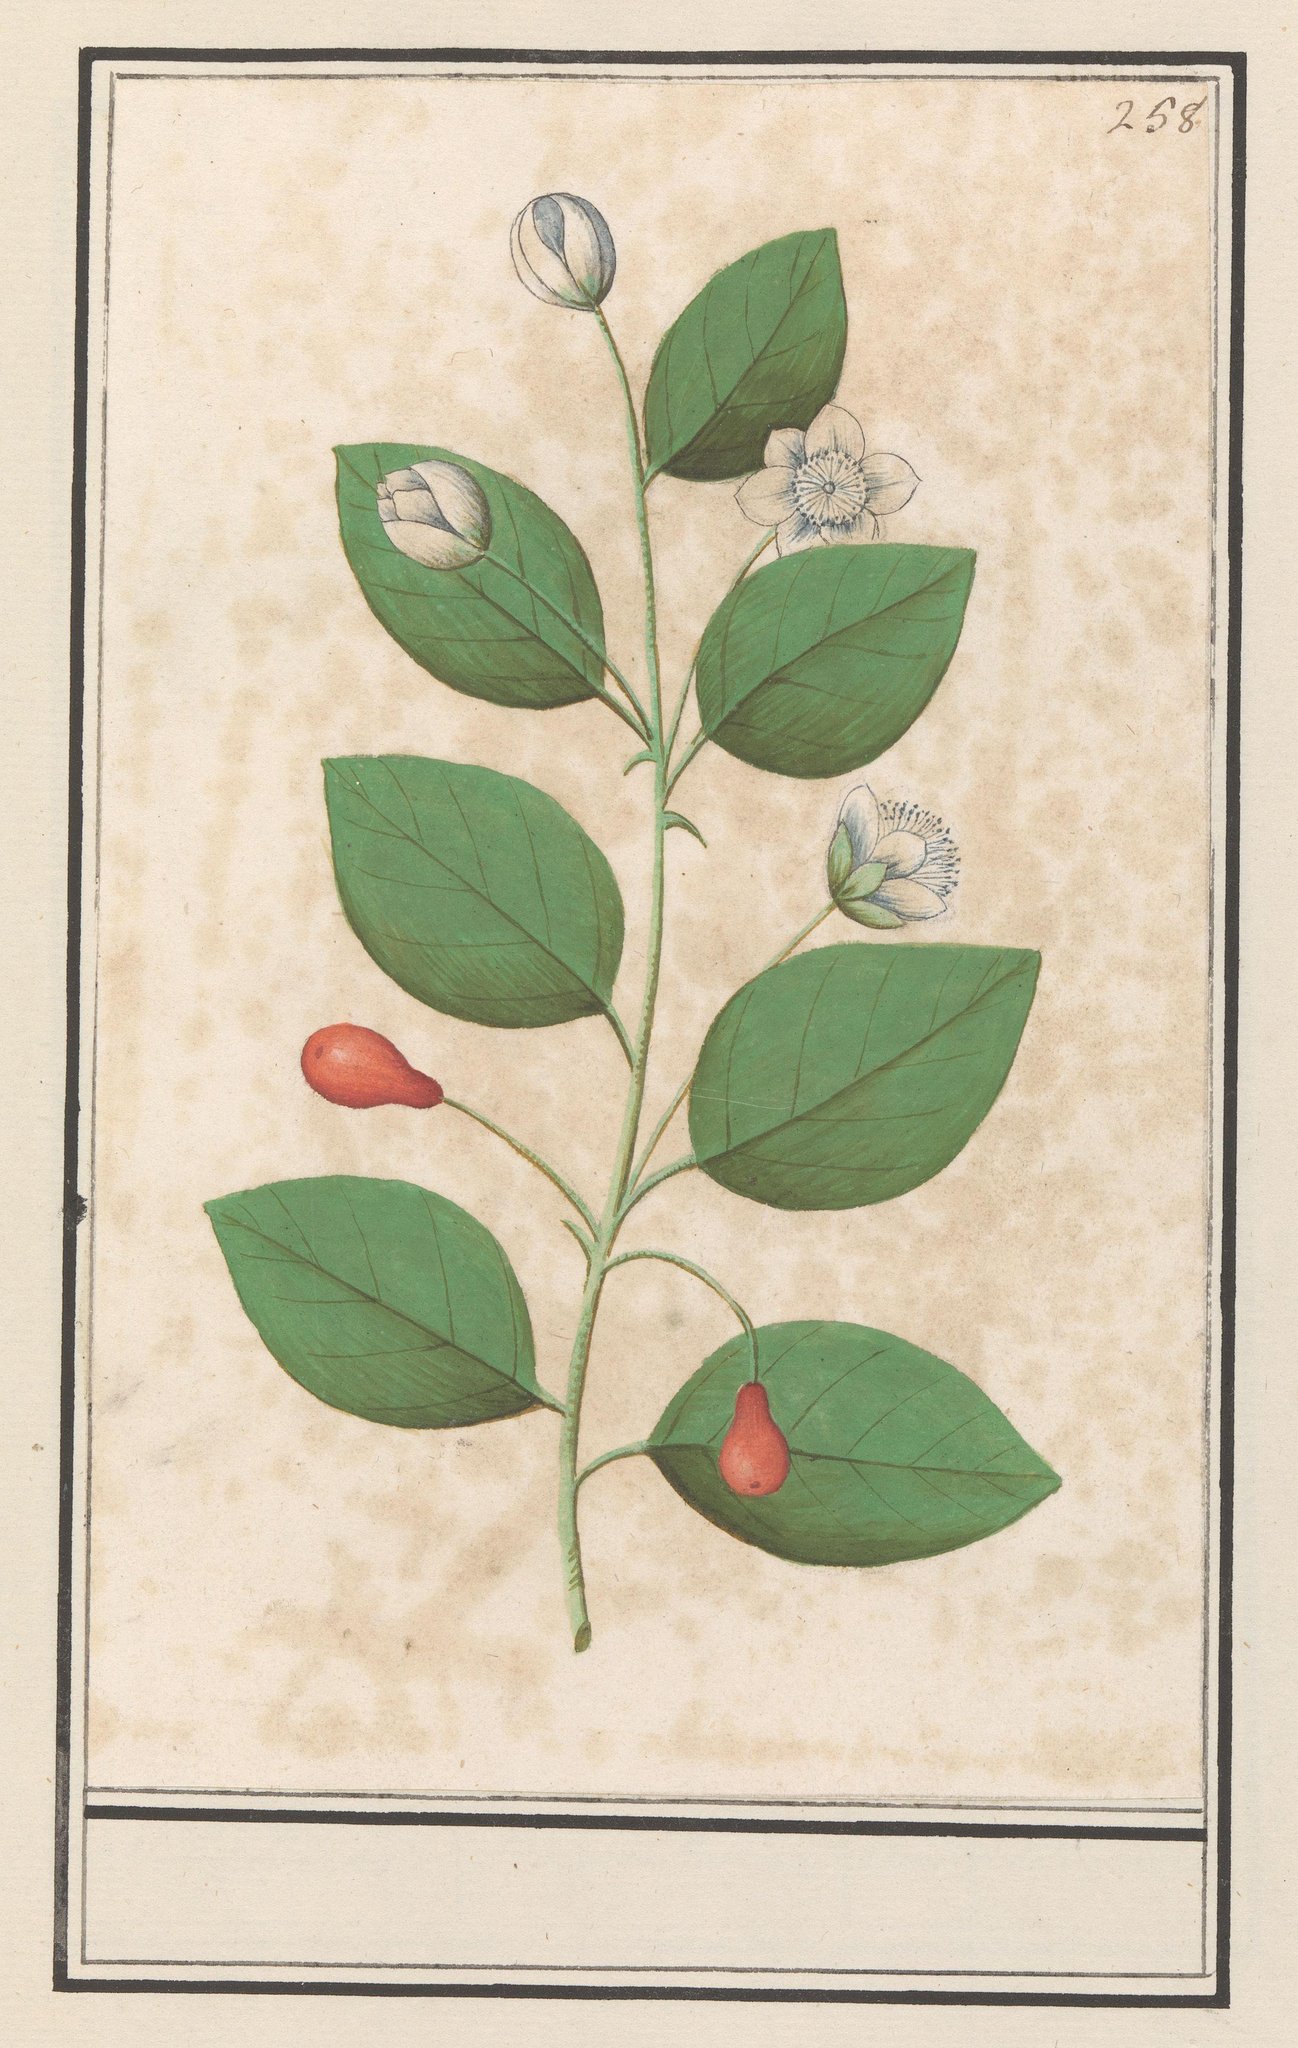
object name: drawing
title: Mirtefamilie (Myrtaceae)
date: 1596-1610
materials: chalk, paint, ink, paper, watercolor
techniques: brush, pen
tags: plants and herbs: myrtle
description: Mirte (waarschijnlijk). Onbekende plant met witte bloemen en rode peervormige bessen. Genummerd rechtsboven: 258. Onderdeel van het derde album met tekeningen van bloemen en planten. Tiende van twaalf albums met tekeningen van dieren, vogels en planten bekend rond 1600, gemaakt in opdracht van keizer Rudolf II. Met toelichting in Nederlands, Latijn en Frans.